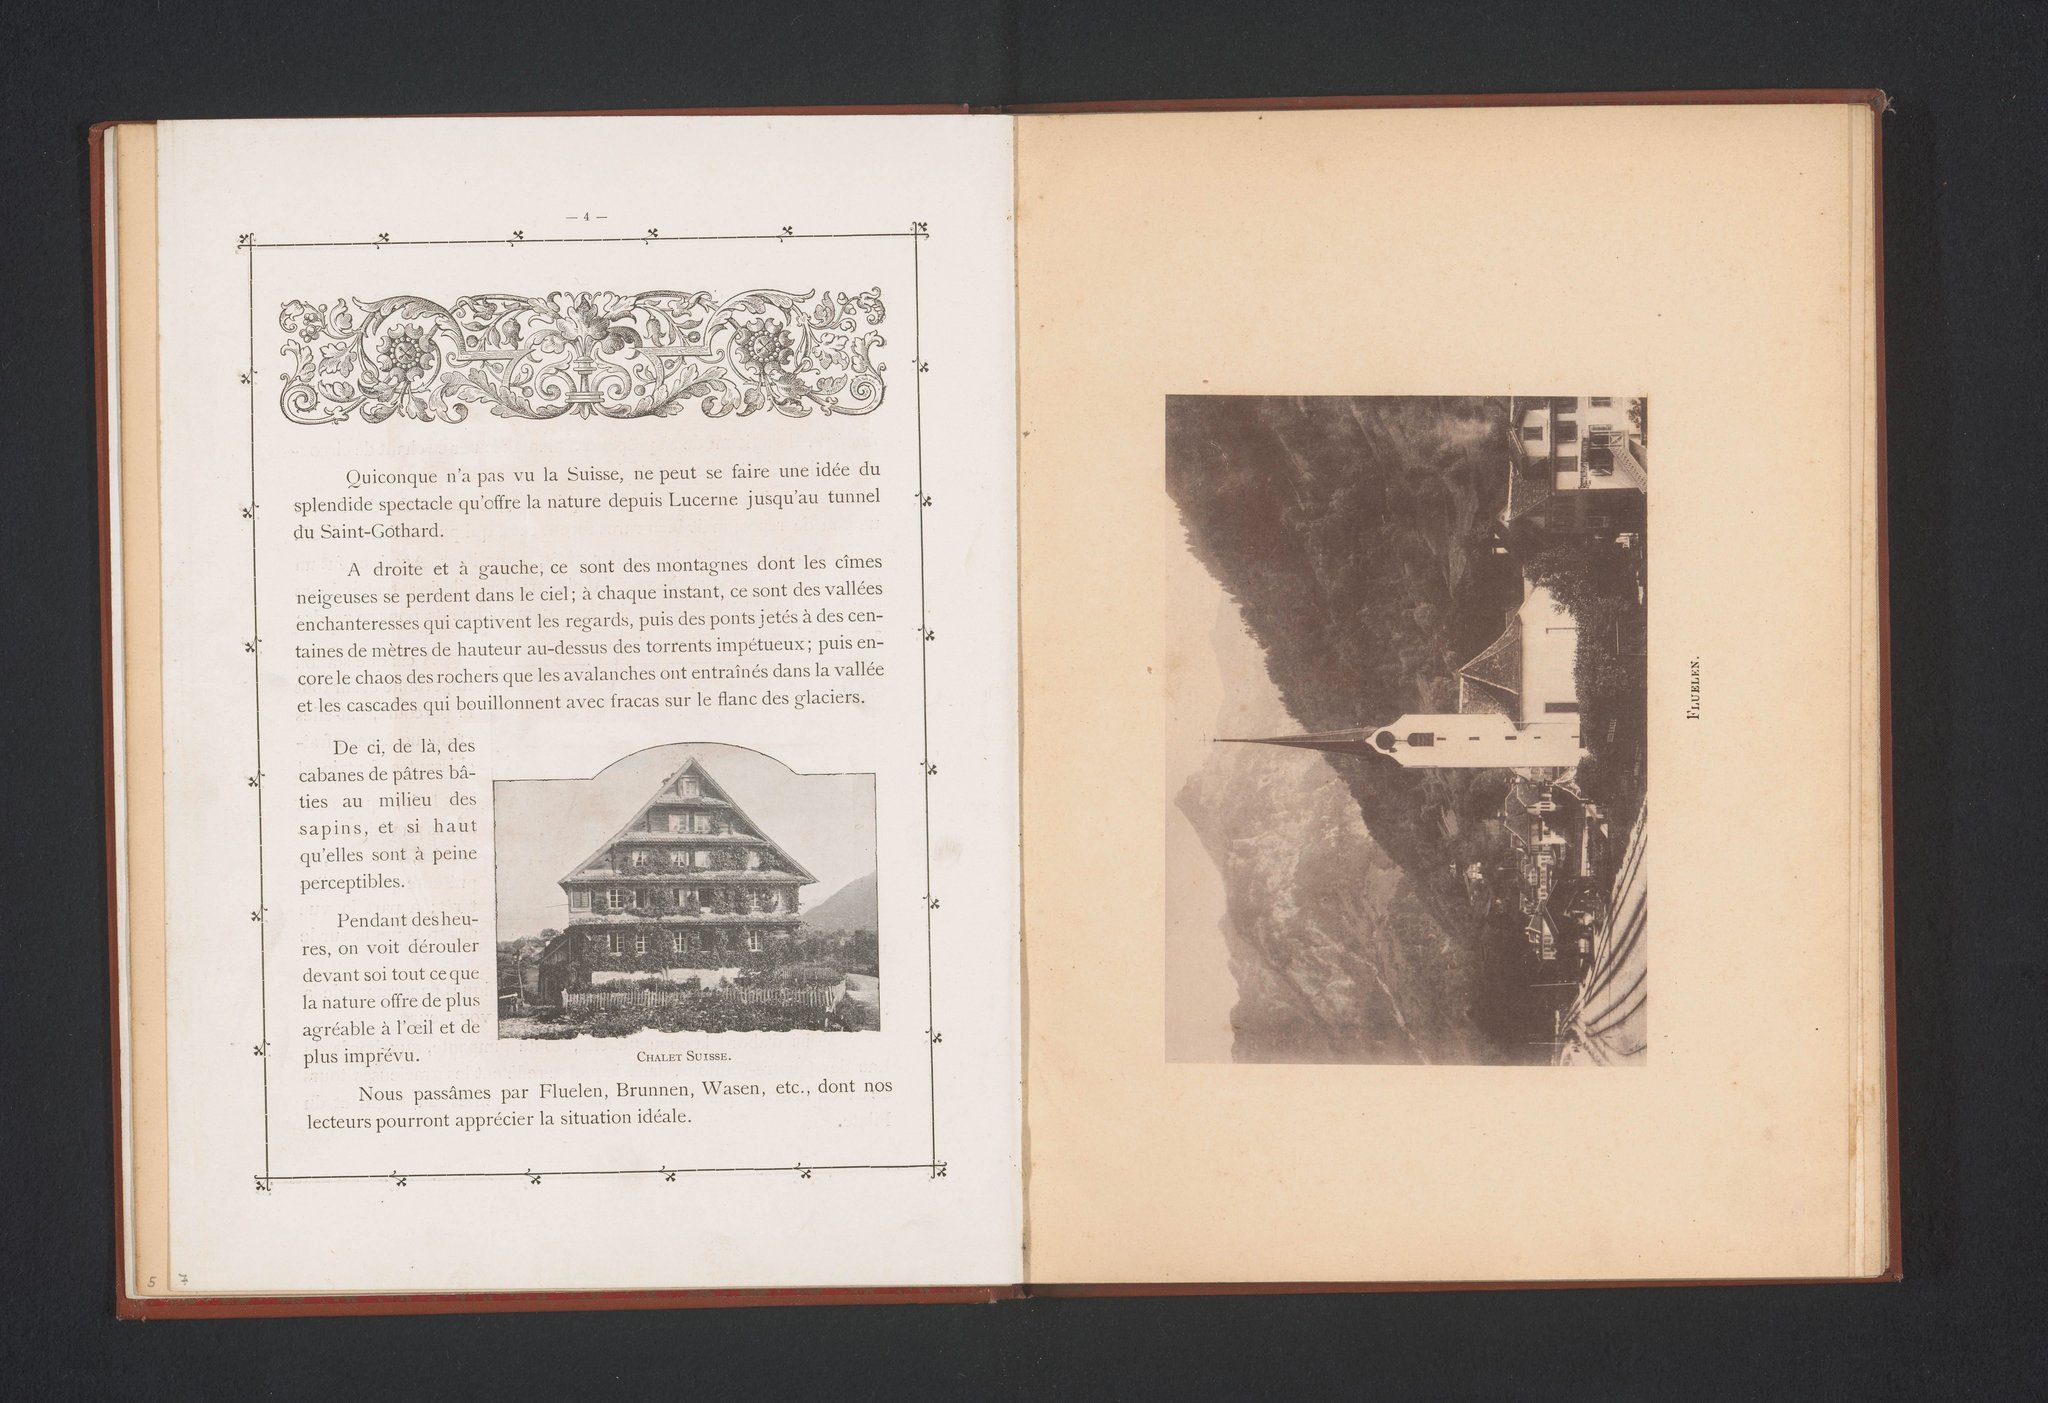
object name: photomechanical print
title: Gezicht op een Zwitsers chalet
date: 1893-1898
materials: paper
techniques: autotype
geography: switzerland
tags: hut, cabin, lodge, switzerland